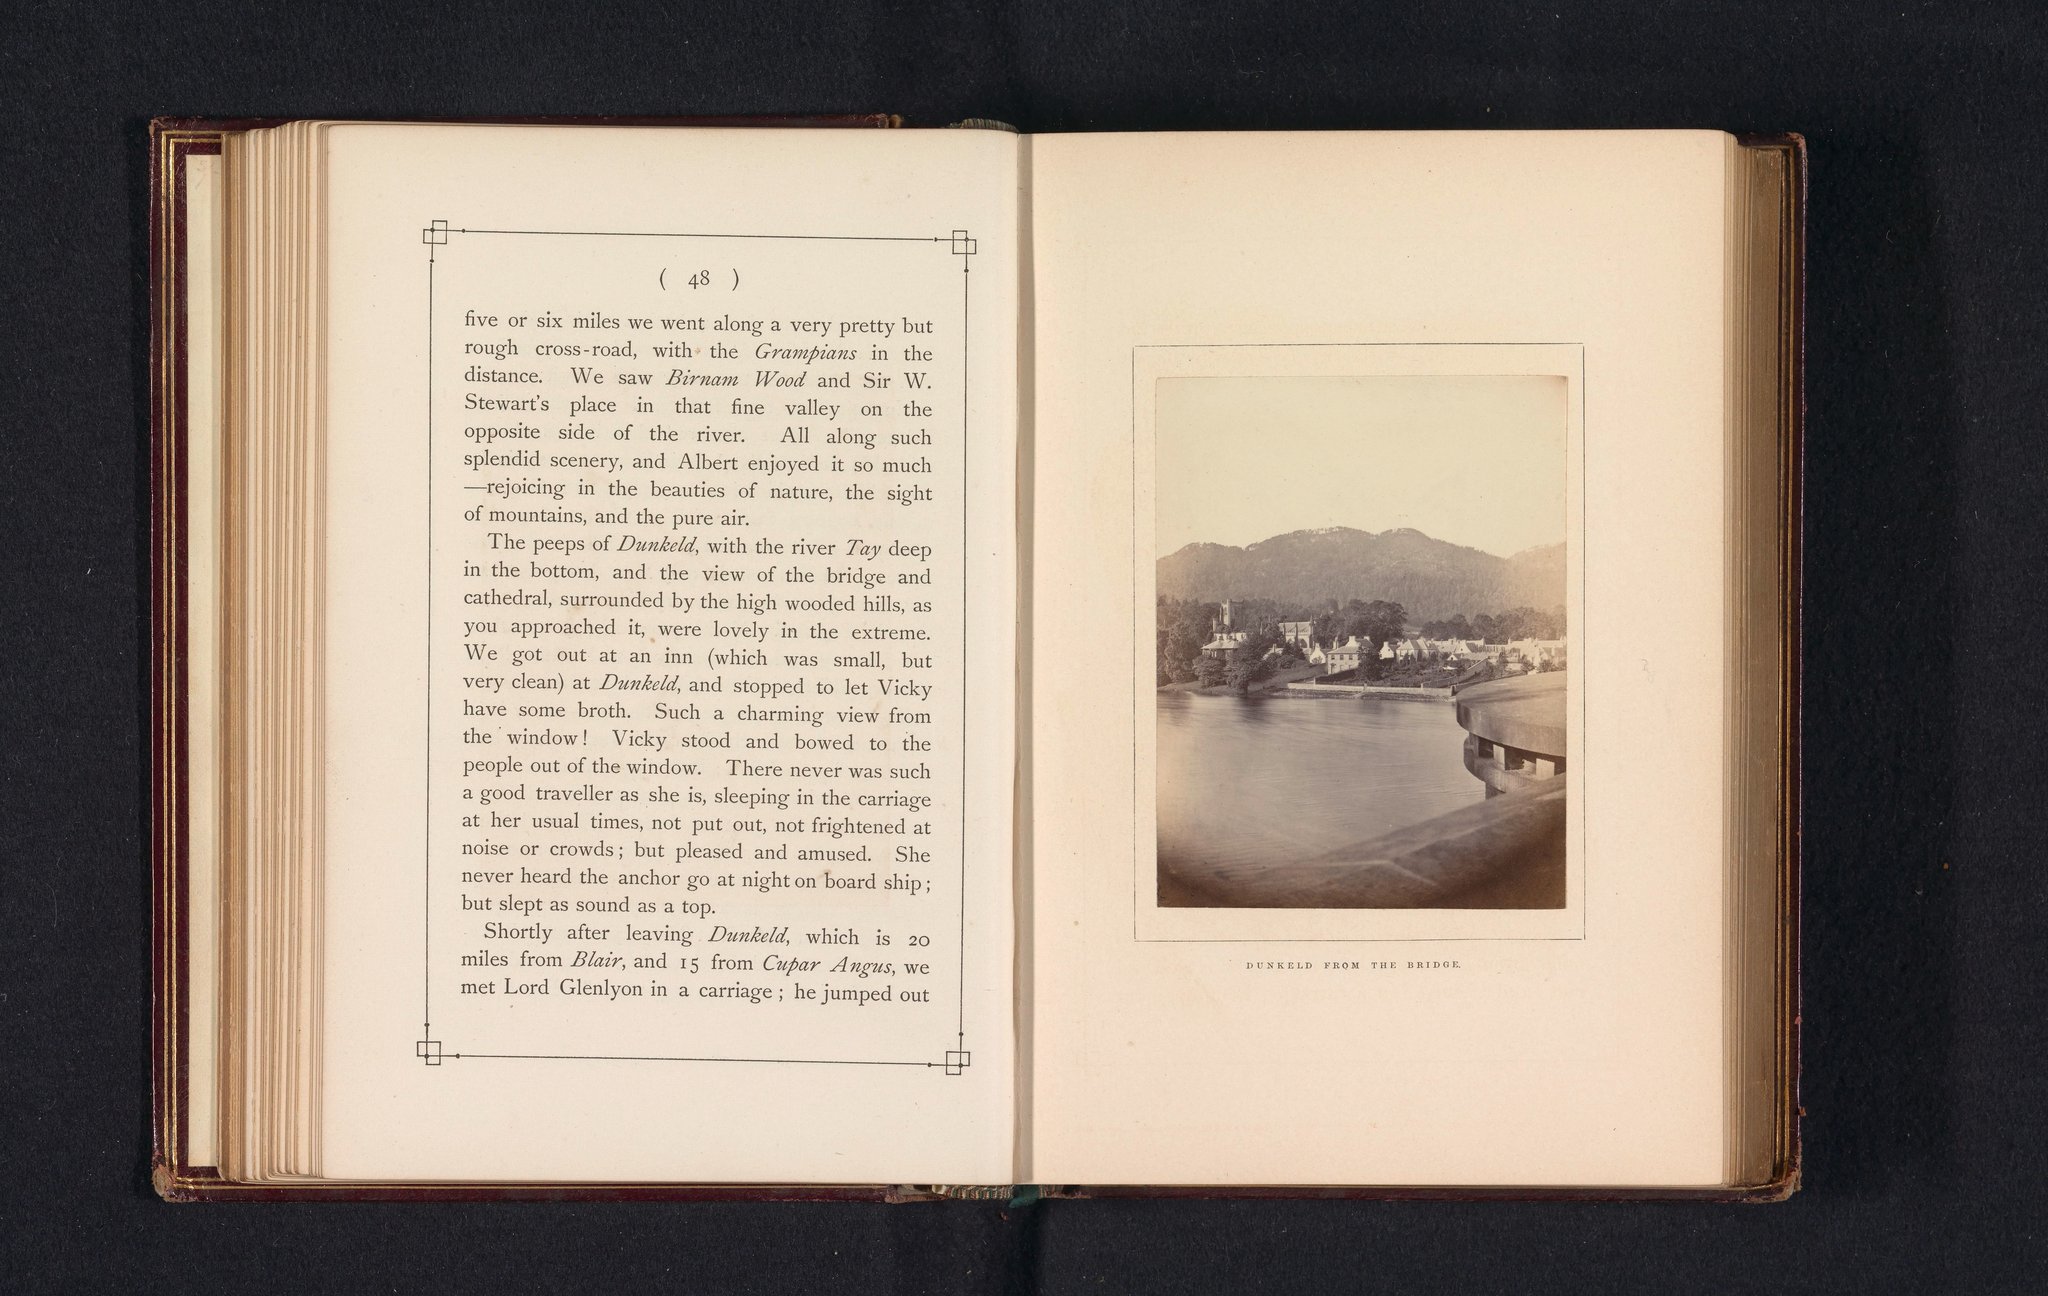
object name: page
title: Dunkeld from the bridge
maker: george washington wilson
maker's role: publisher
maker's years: 1823-1893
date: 1858-1868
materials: photographic support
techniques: albumen print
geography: dunkeld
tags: city-view, and landscape with man-made constructions, river, bridge in city across river, canal, etc.